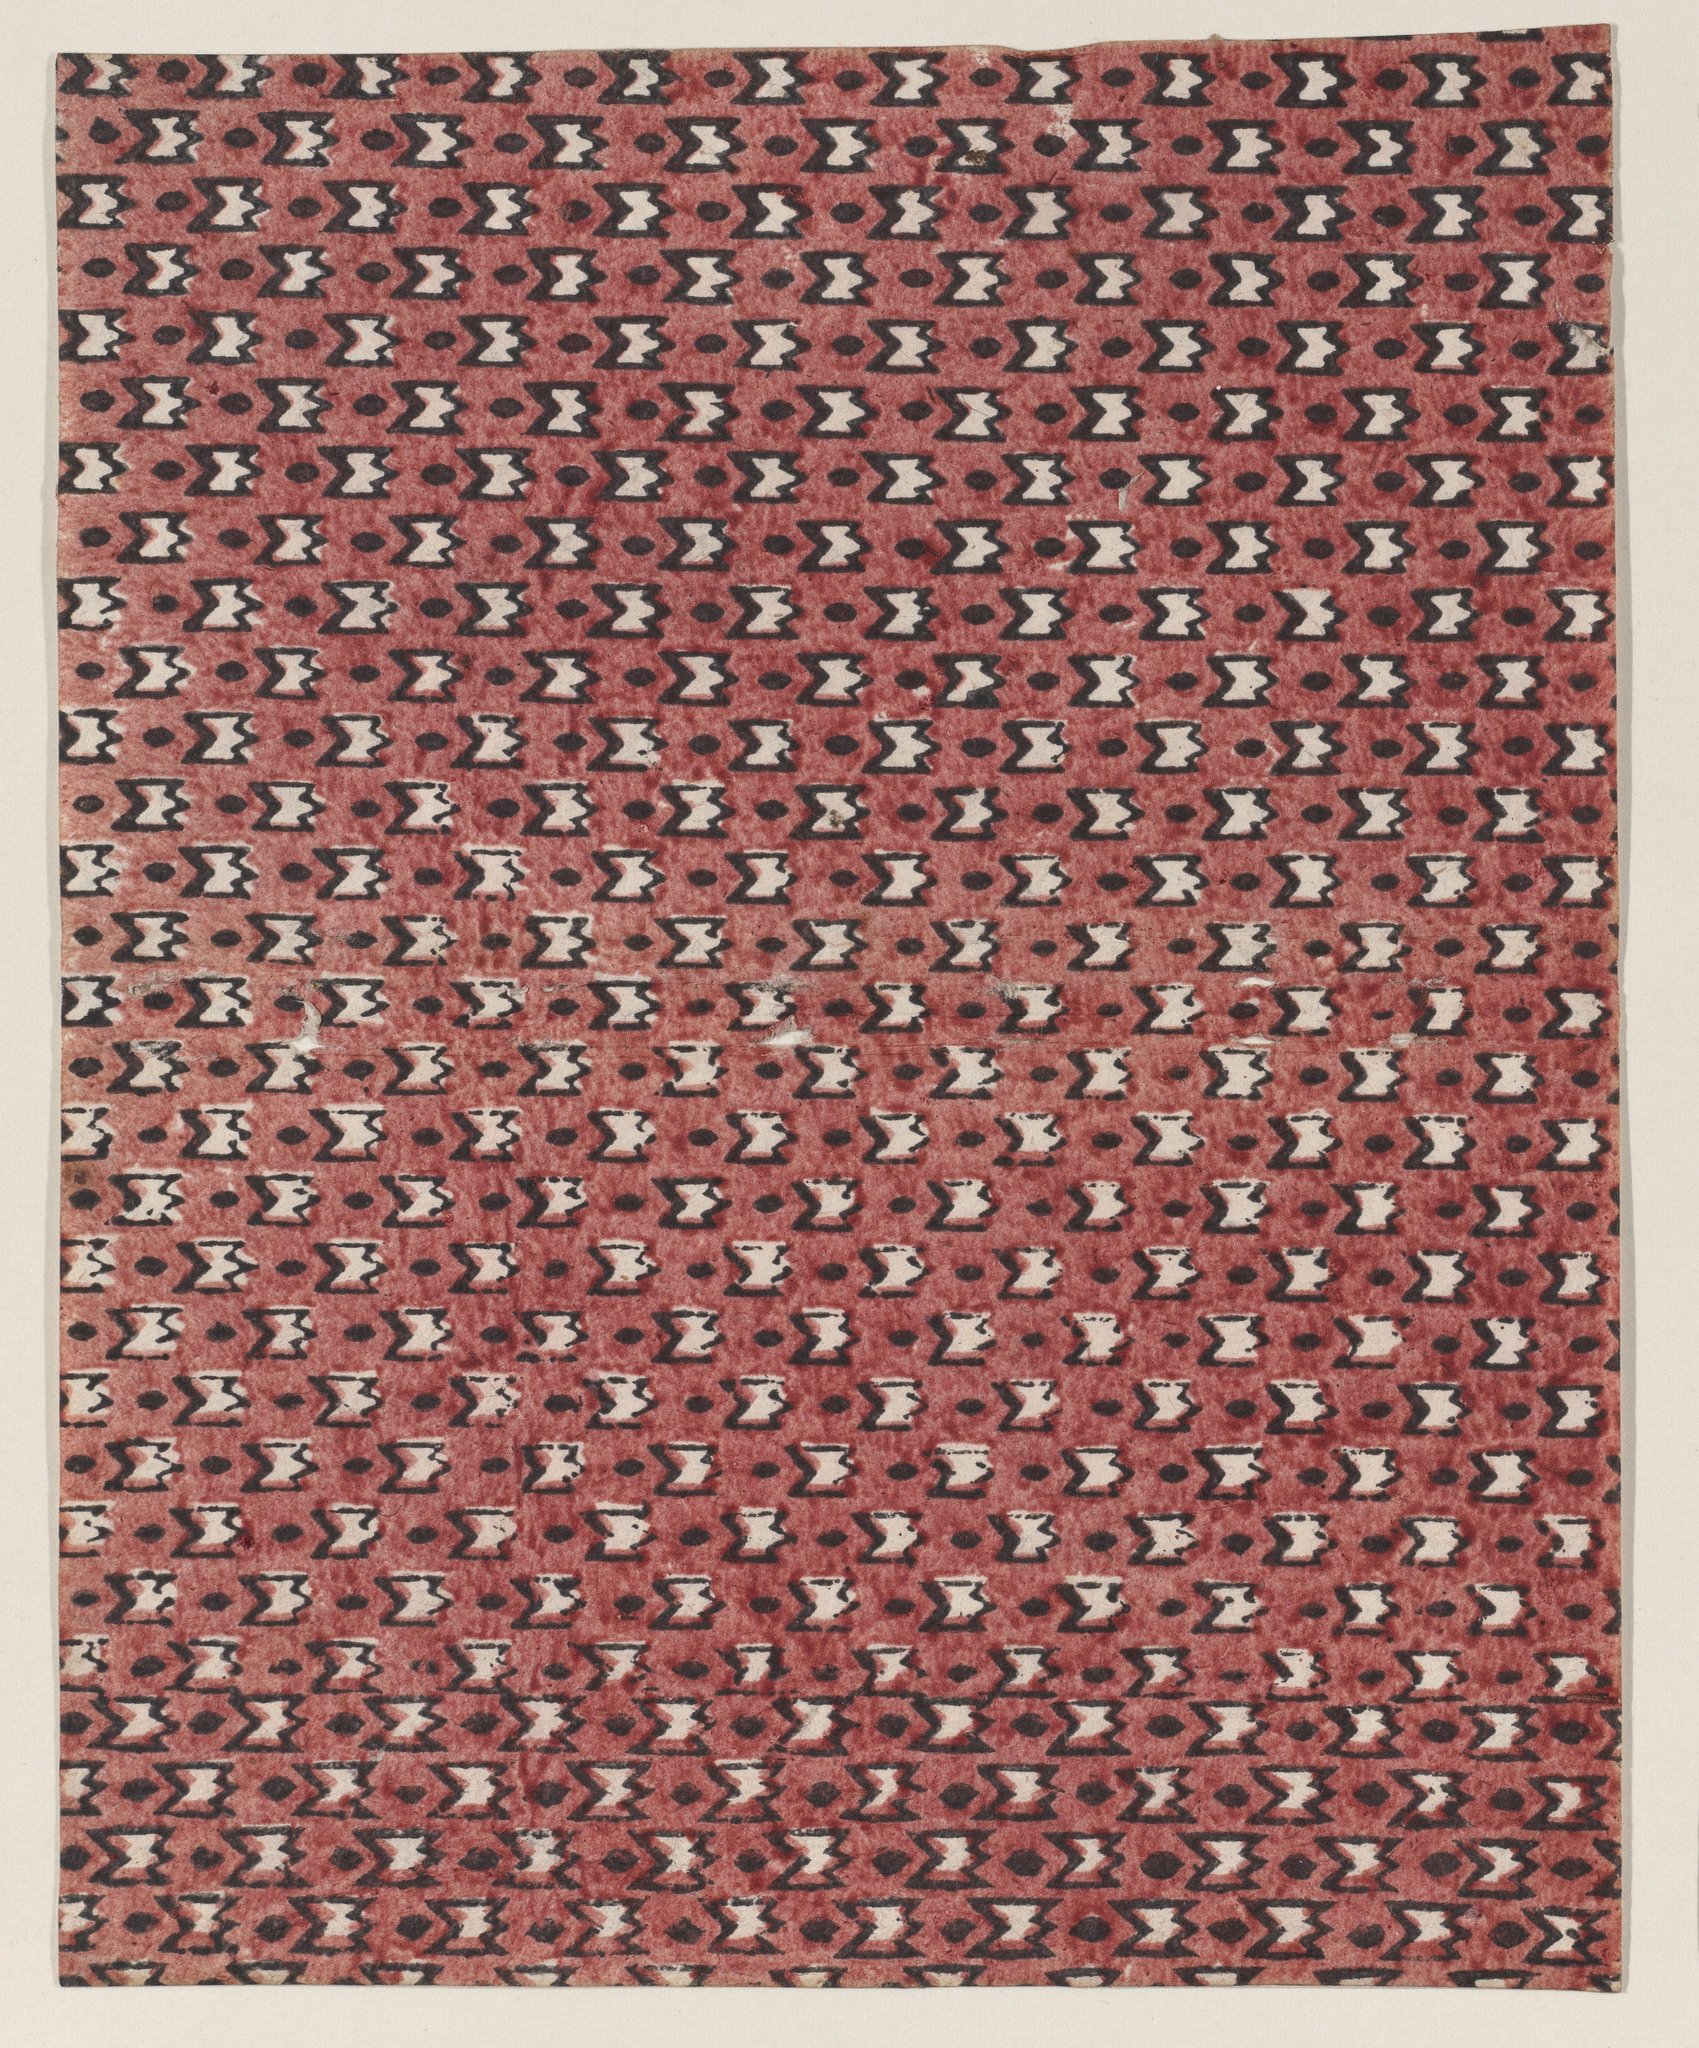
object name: print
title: Sheet with overall red and black geometric pattern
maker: Anonymous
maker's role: artist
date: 1801-1900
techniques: relief print